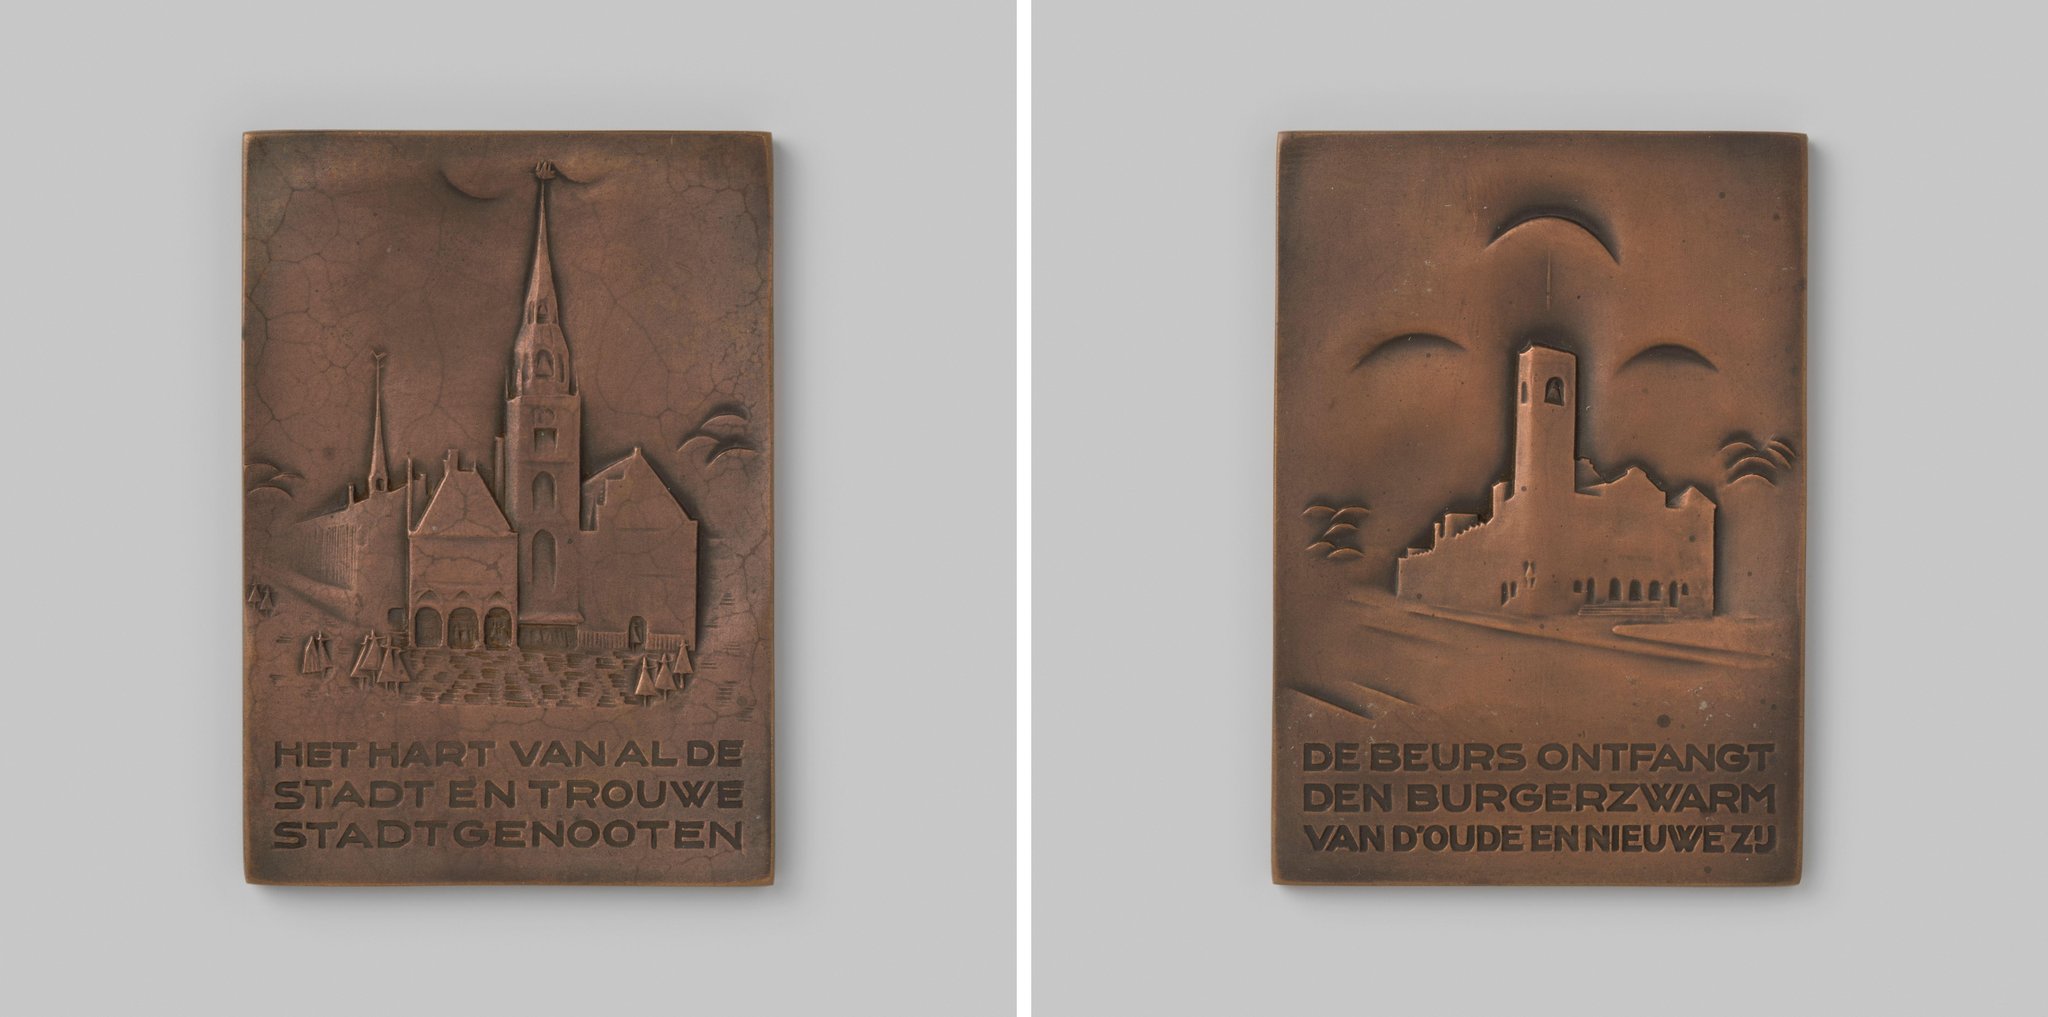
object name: history medal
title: Zeshonderdvijftigjarig bestaan van de stad Amsterdam 1925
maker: j. richters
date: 1925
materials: copper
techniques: striking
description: Rechthoekige koperen plakette, op de voorzijde het oude stadhuis van Amsterdam waaronder drie regels incuse tekst, op de keerzijde de Beurs van Berlage waaronder drie regels incuse tekst.